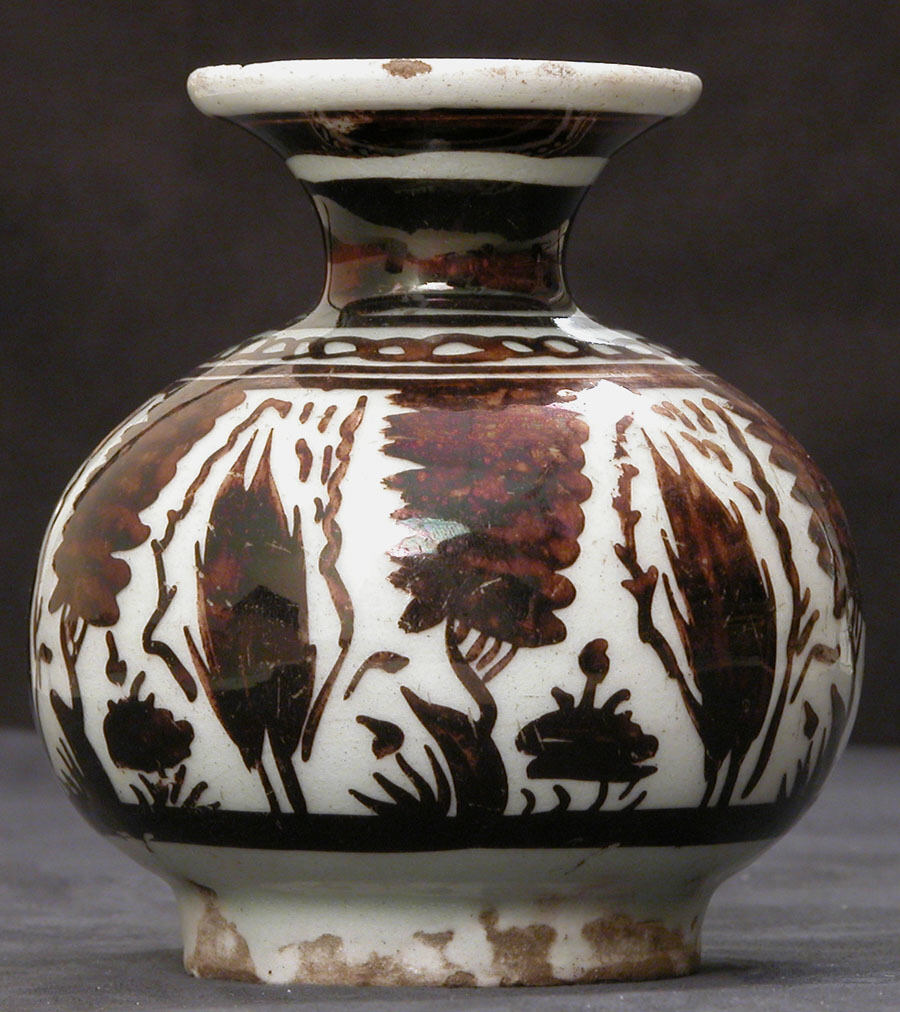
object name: vase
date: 1601-1800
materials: glaze, stonepaste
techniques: luster painting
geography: iran